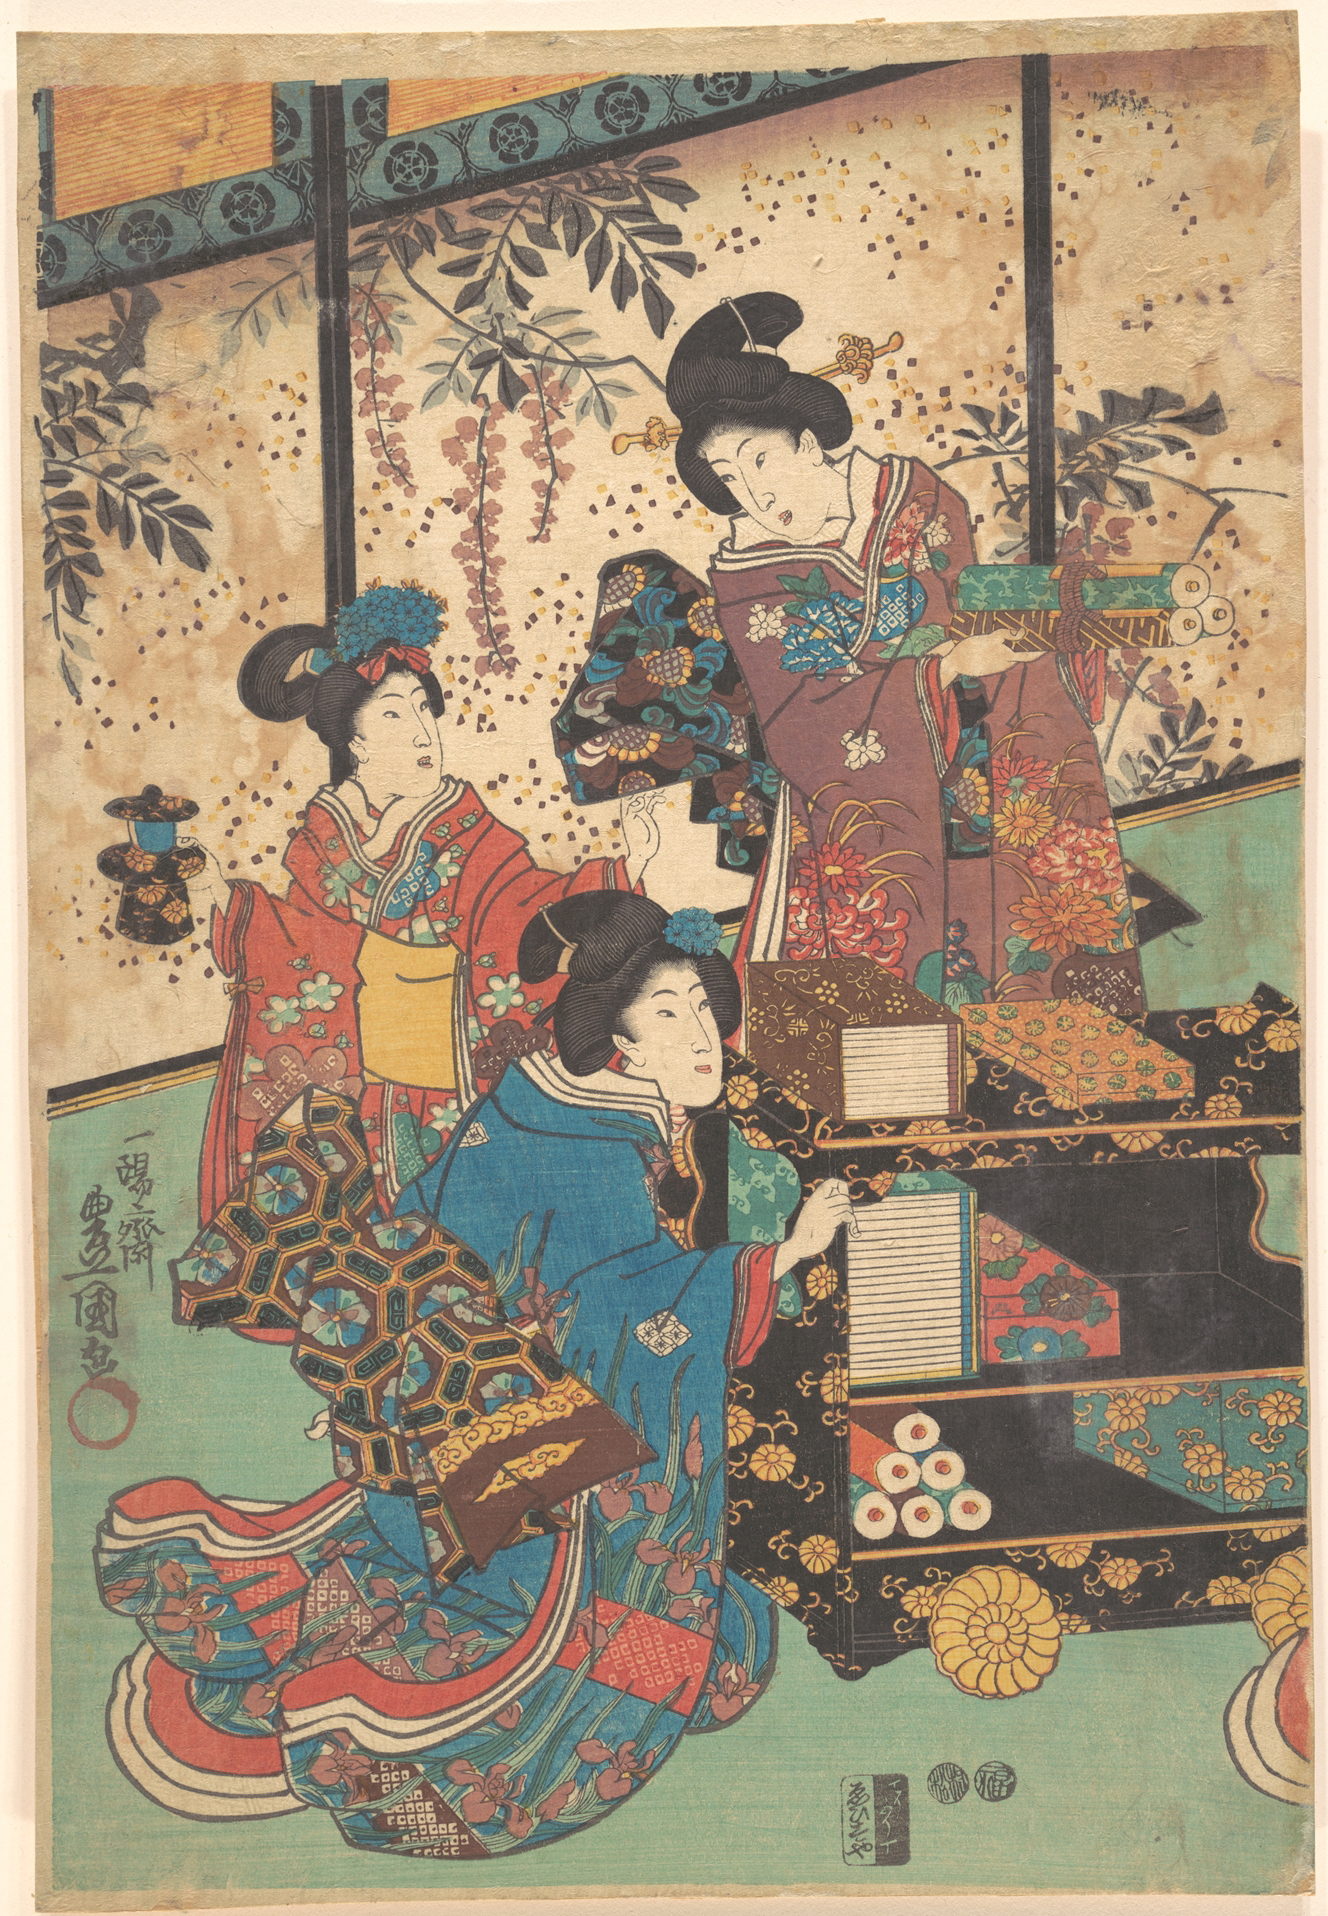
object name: print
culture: japanese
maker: utagawa kunisada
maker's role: artist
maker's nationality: japanese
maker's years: 1786-1864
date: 1786-1854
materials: ink, paper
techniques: woodblock print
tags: women,furniture